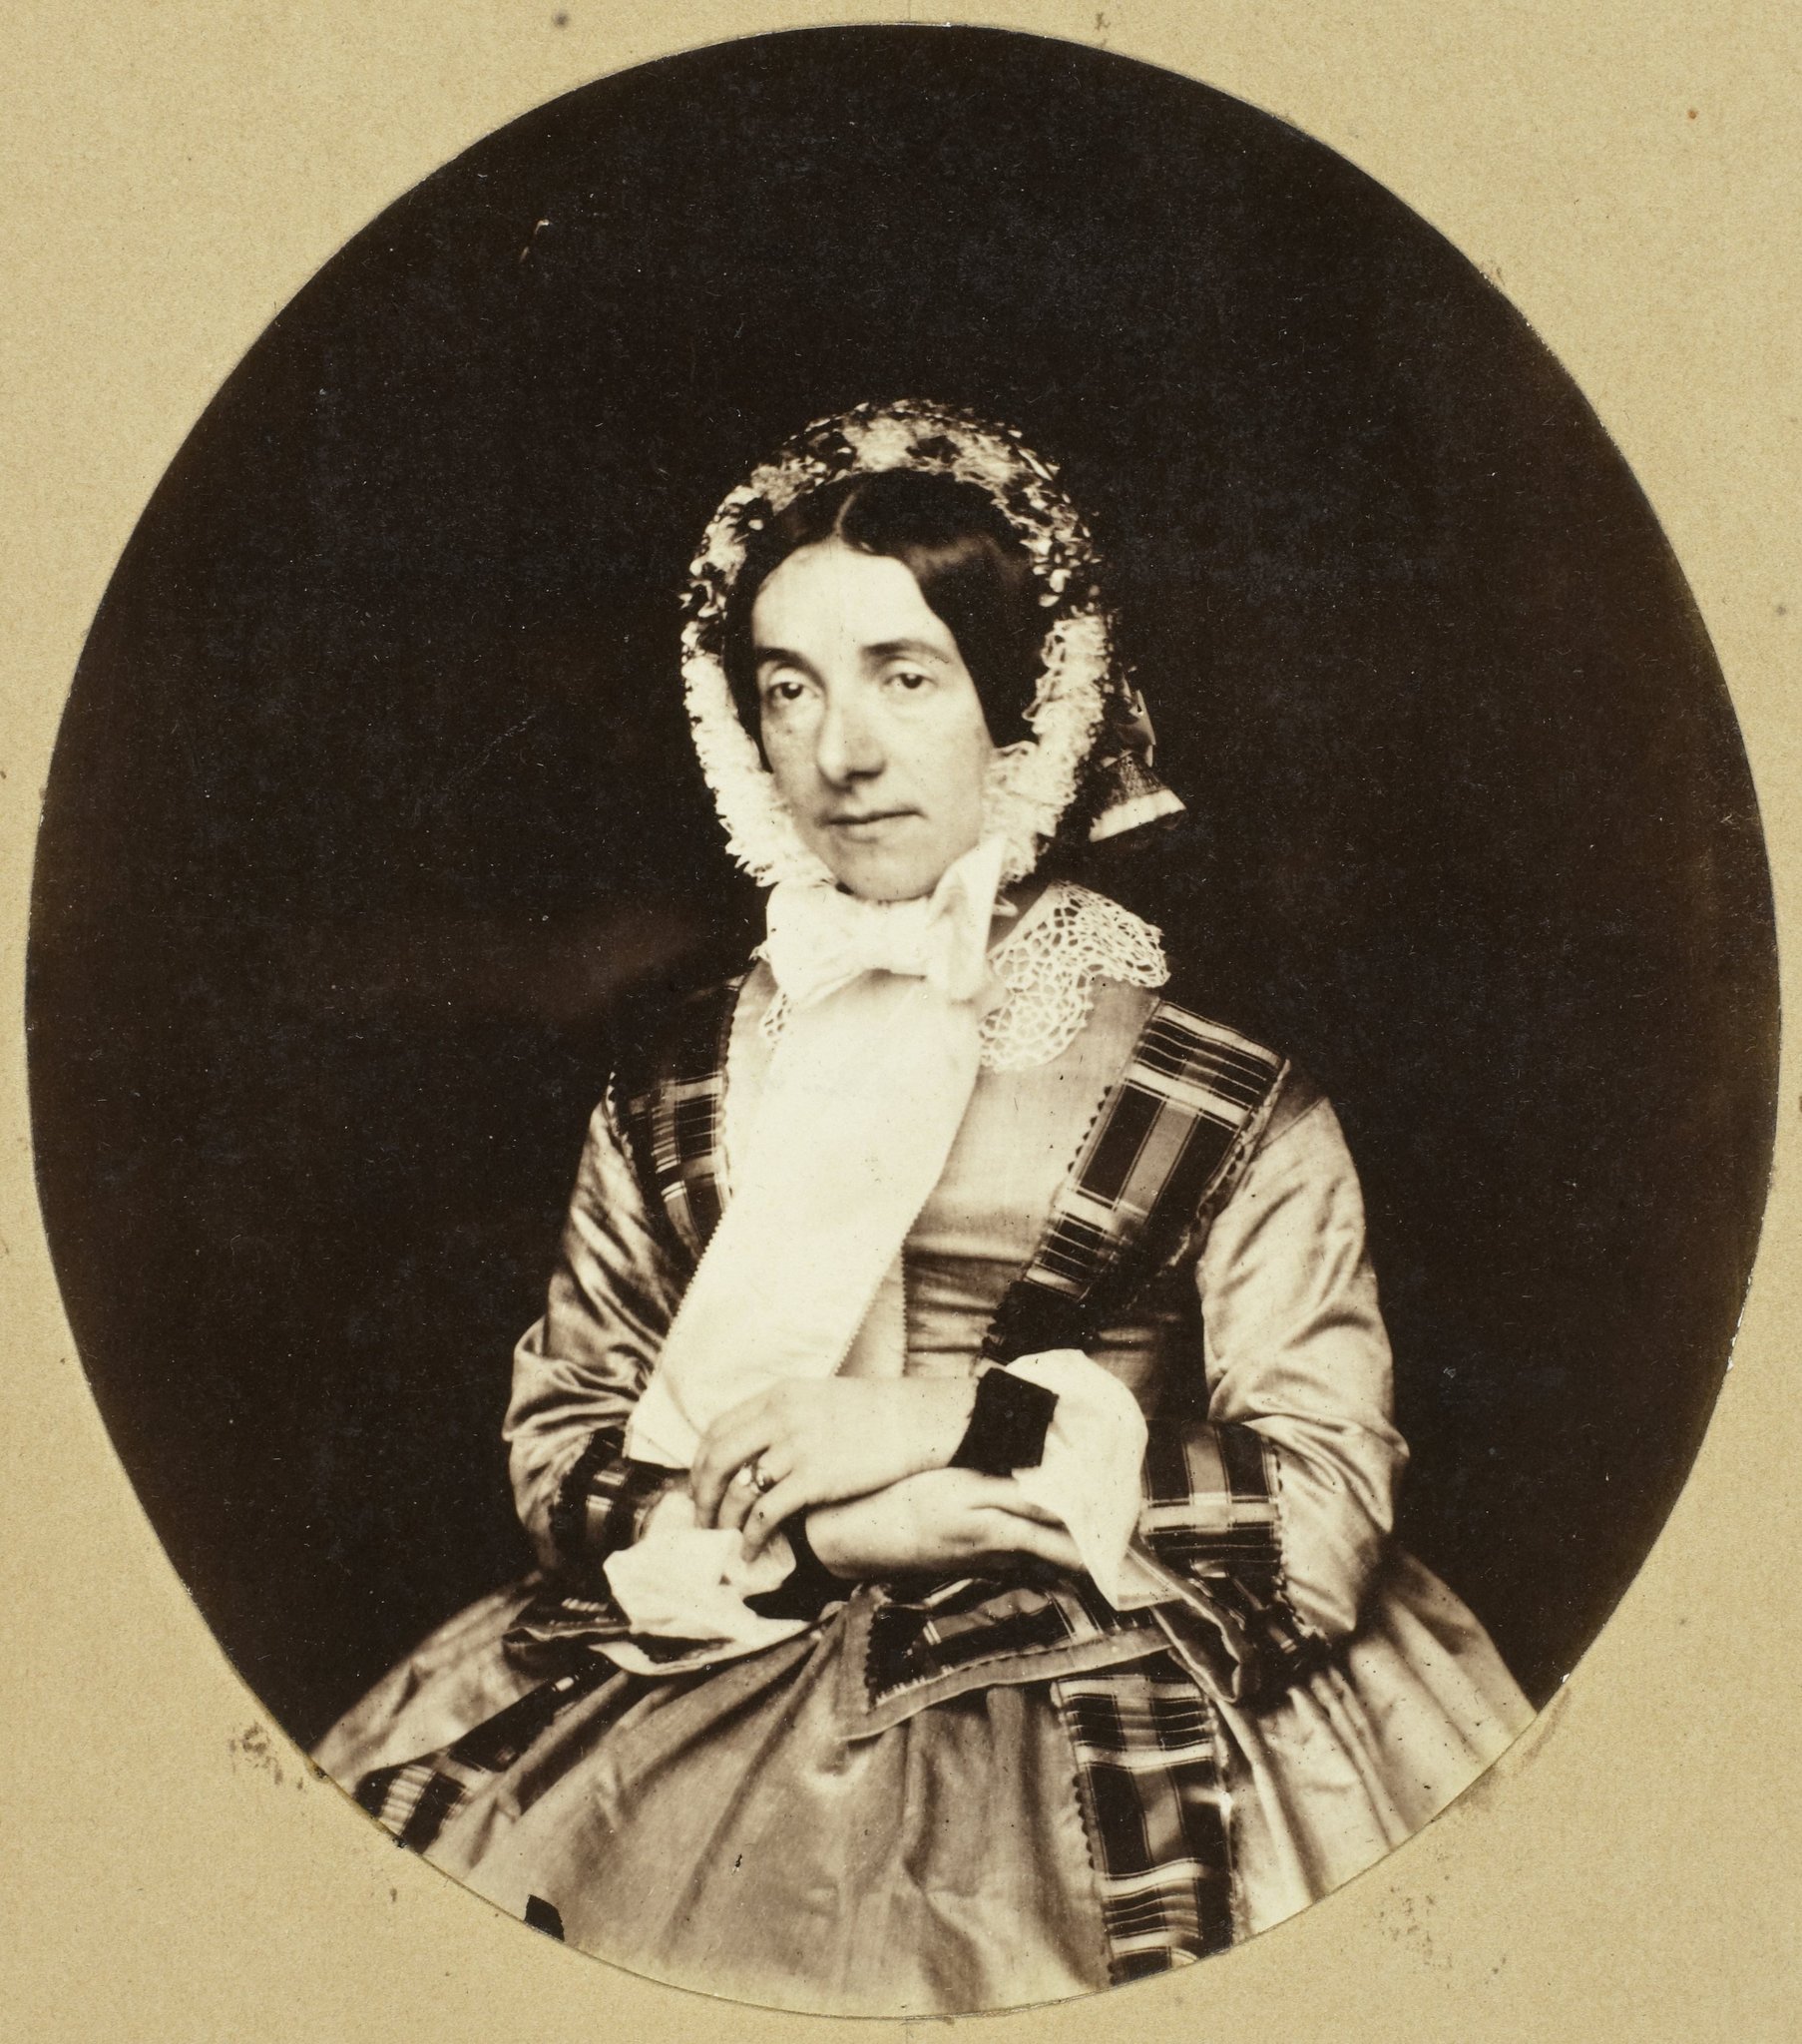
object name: photograph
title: Portret van Elisa Beer-Oppenheim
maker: eduard isaac asser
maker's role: amateurfotograaf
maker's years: 1809-1894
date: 1854-1855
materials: cardboard, paper, photographic support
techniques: salted paper print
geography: amsterdam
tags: historical persons - bb - woman